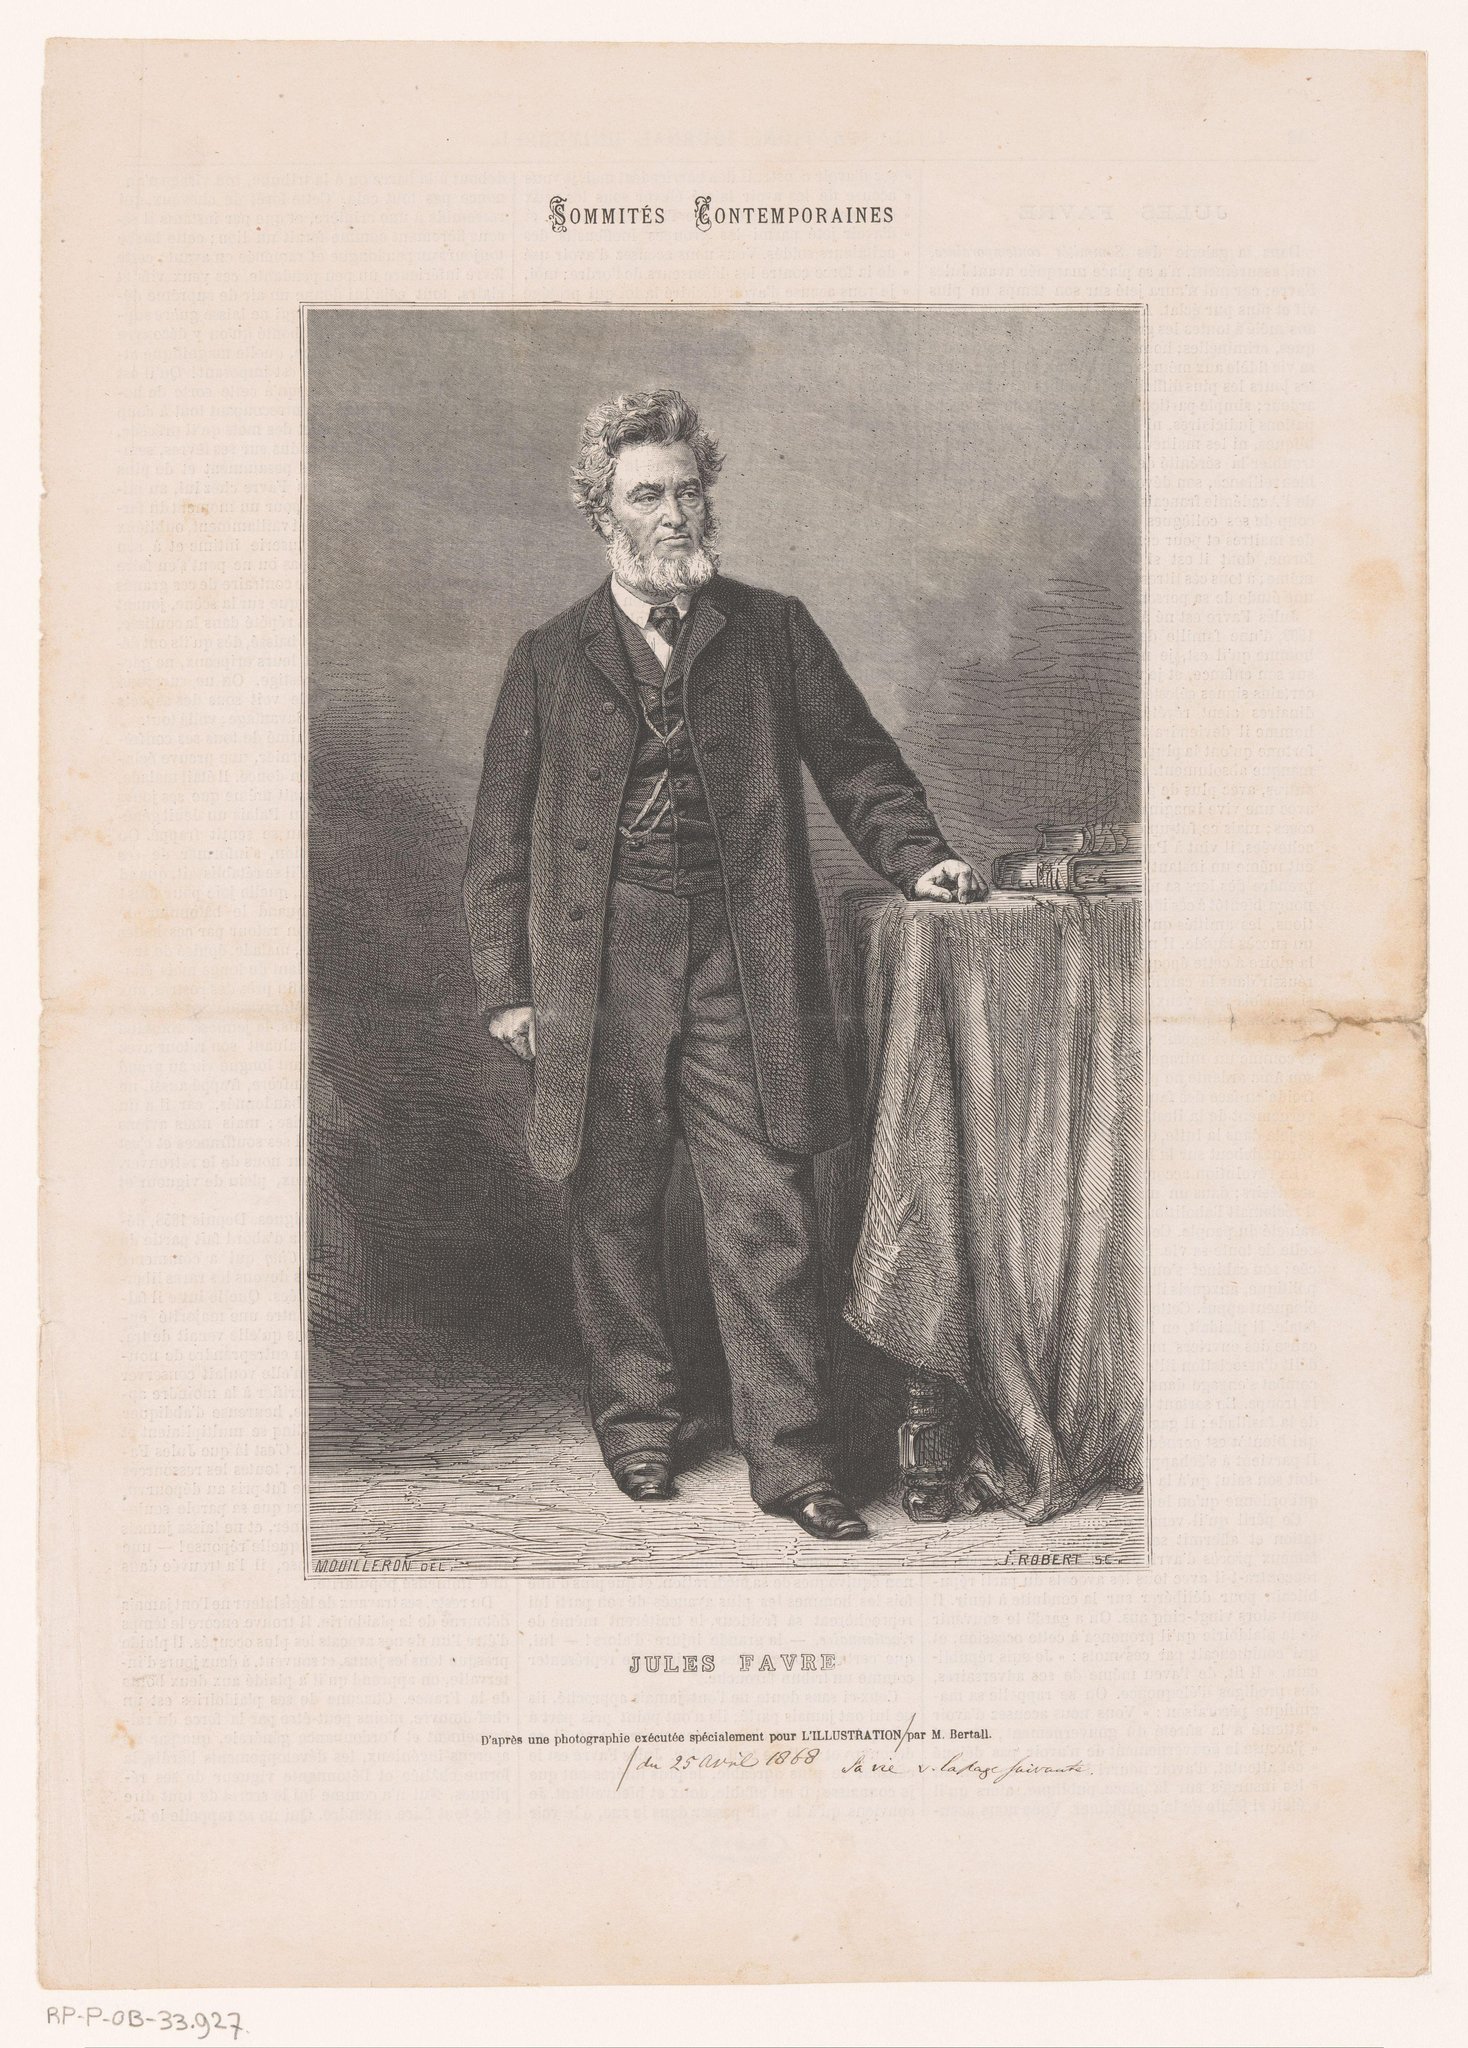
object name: print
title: Jules Favre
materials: paper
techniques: letterpress printing, engraving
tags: lyon, politician, historical persons, politician, e.g. party leader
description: Prent uit: L'Illustration, 25 april 1868.